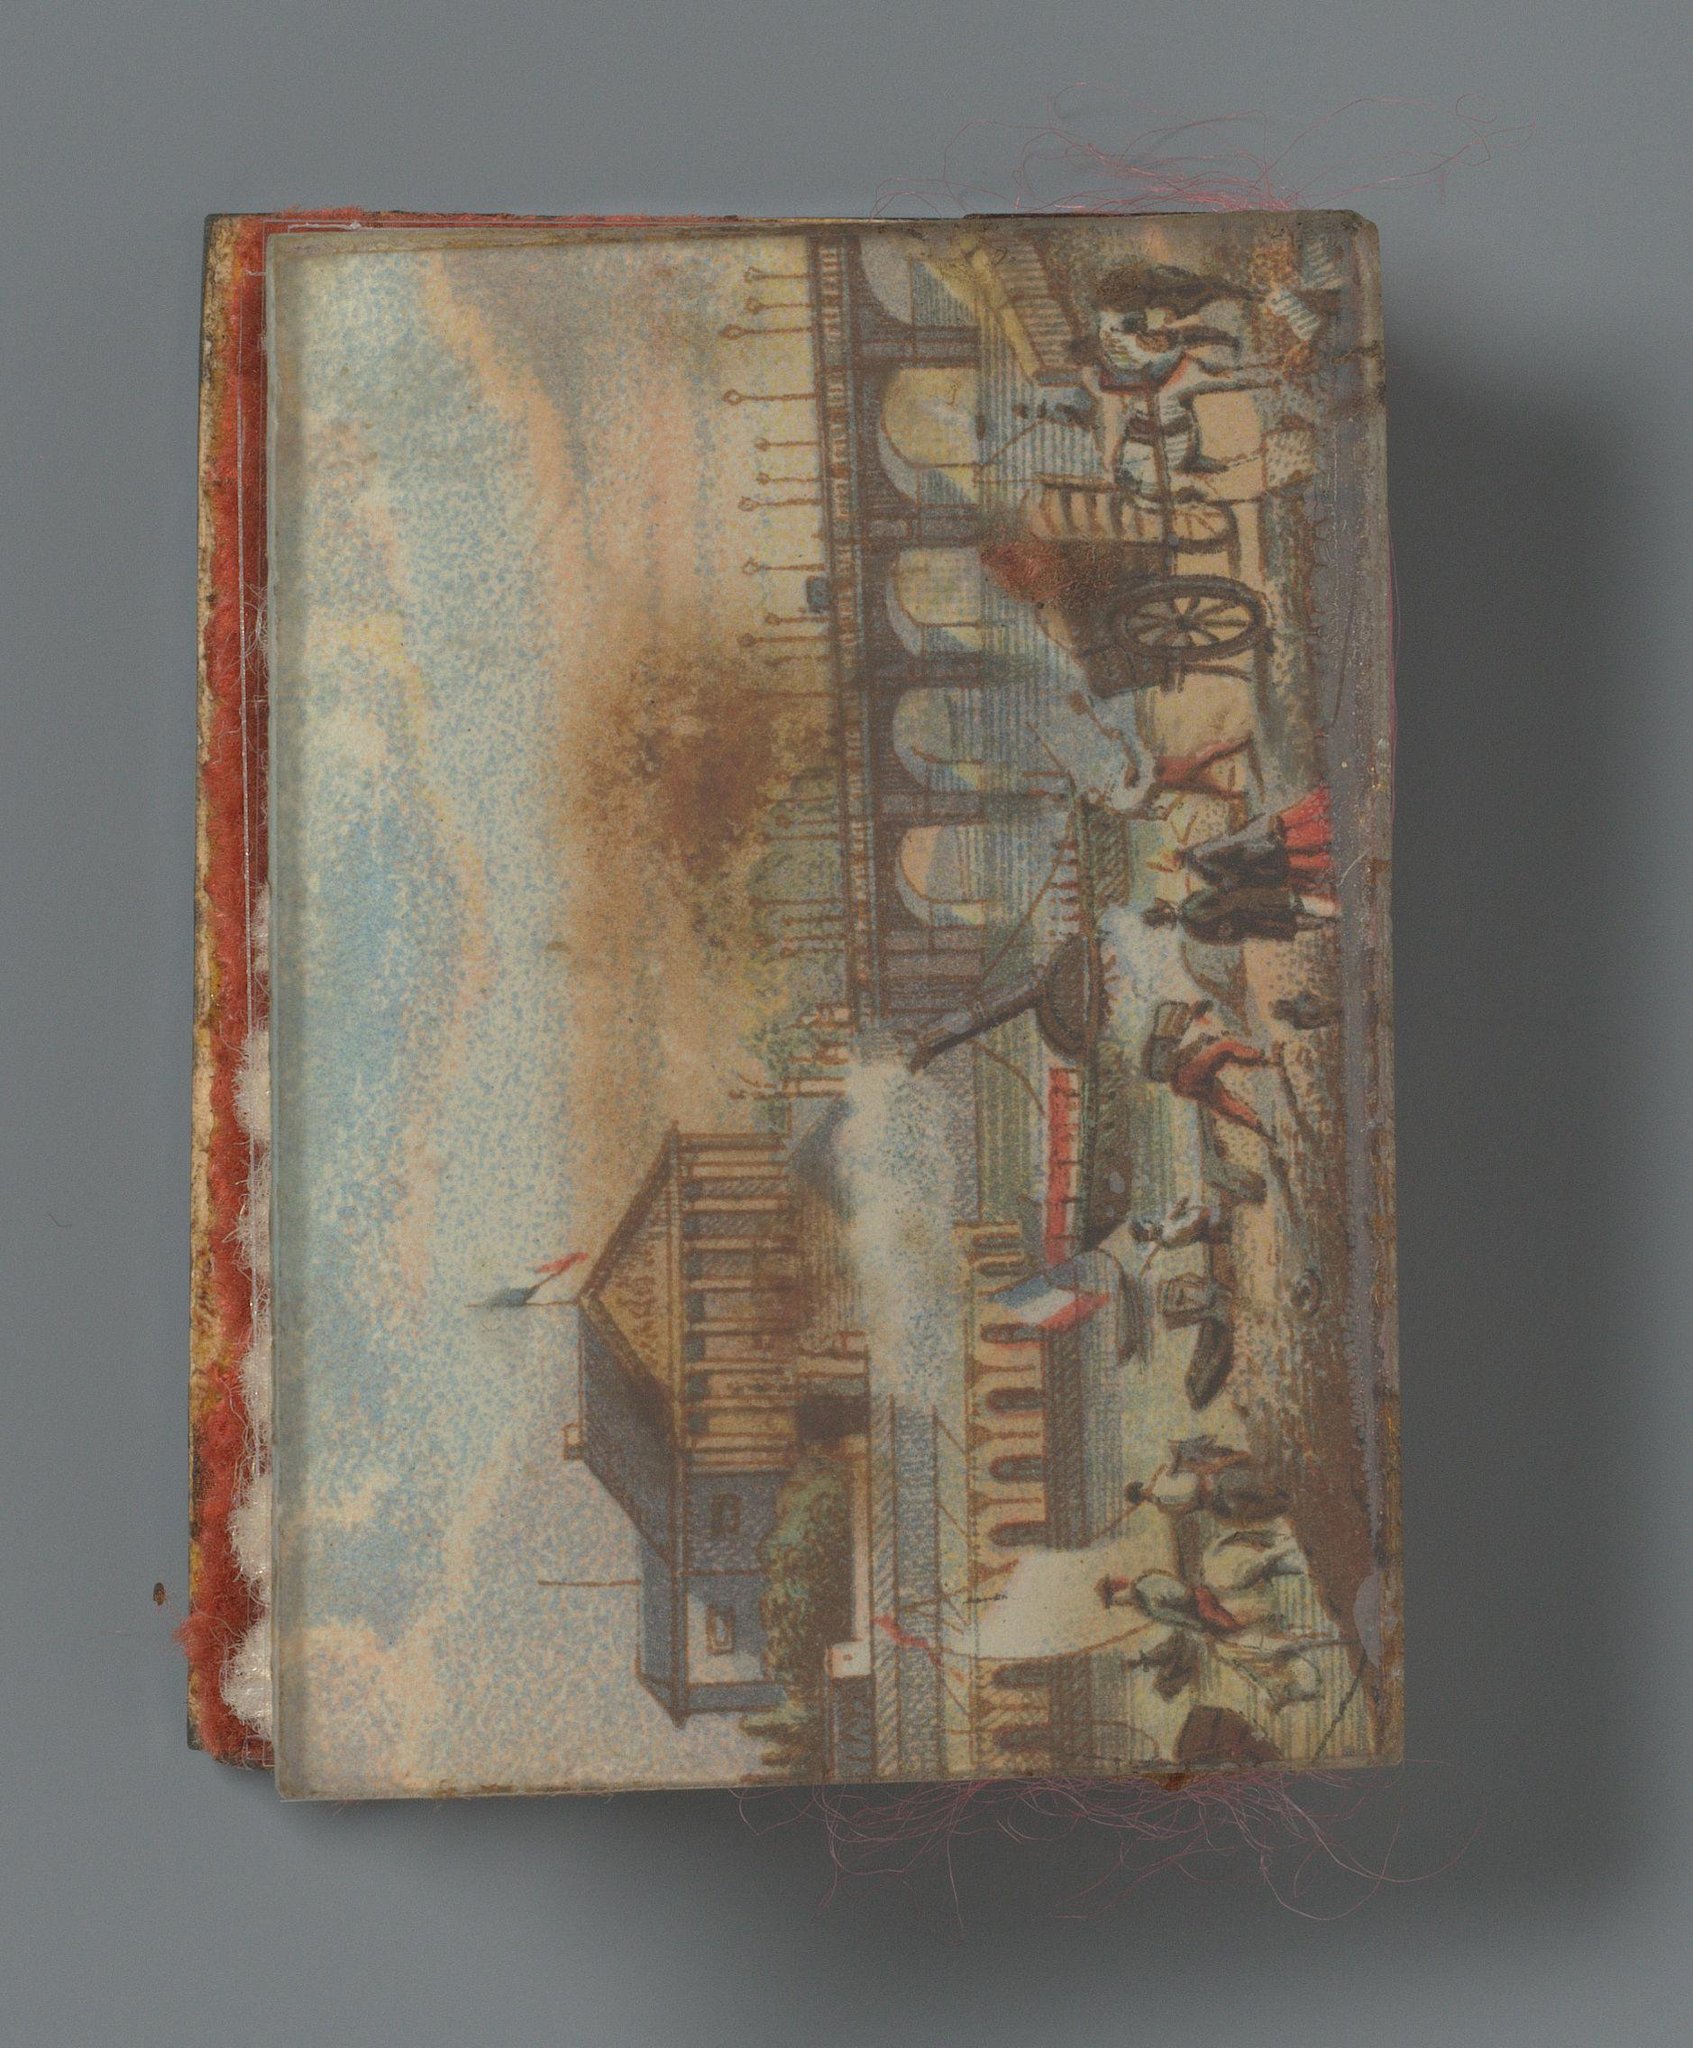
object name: sewing kit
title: Scène in Parijs, achter glas op naaigarnituur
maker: Anonymous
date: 1860-1870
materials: glass, paper, velvet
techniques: lithograph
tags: bridge in city across river, canal, etc., paris